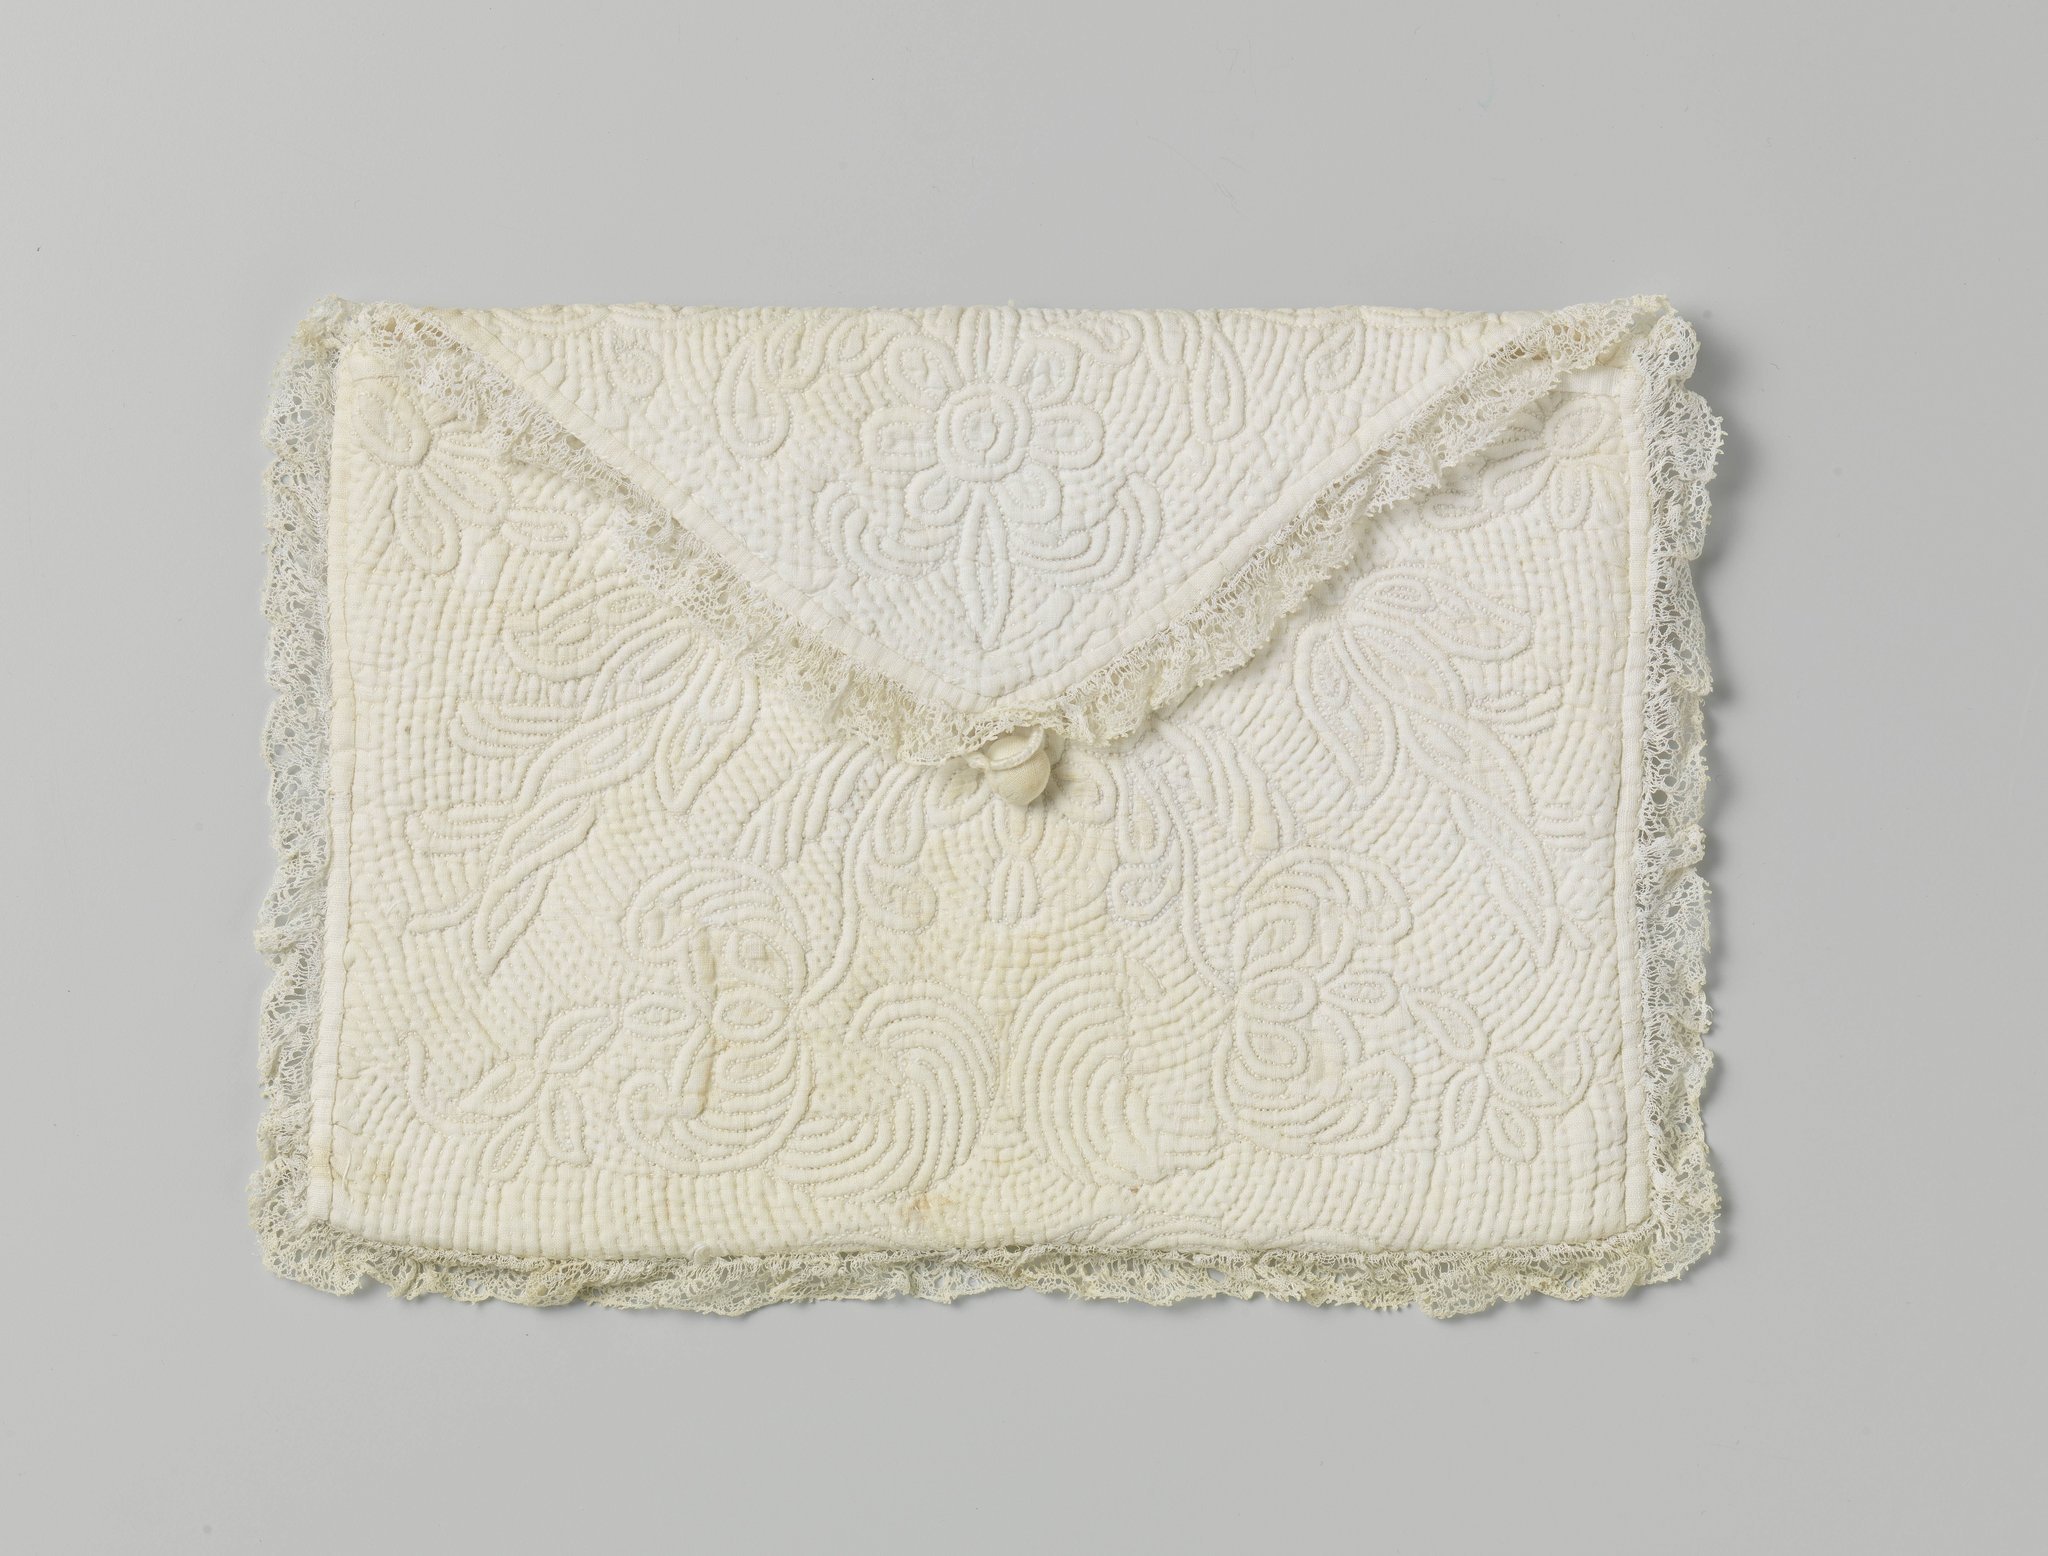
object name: bag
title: Brieventas van witte katoen versierd met florale motieven in 'point de Marseille' of Zaans stikwerk, rondom afgezet met een smalle strook kloskant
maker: Anonymous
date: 1750-1770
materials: cotton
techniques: lace, quilting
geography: zaanstreek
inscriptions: circumscription: ‘'Zaans stikwerk, 18e eeuw, met kloskant. Zakje voor speldenkussen. Het is uitgevoerd in Zaans Stikwerk. Beschrijving van hierboven. Het is versierd met een eenvoudig kantje. Geschenk van mevrouw Schuurman-Meeters te Arnhem'’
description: Brieventas van witte katoen versierd met florale motieven in 'point de Marseille' of Zaans stikwerk, rondom afgezet met een smalle strook kloskant. Het stikwerk heeft een symmetrische opbouw van gestileerde bloemmotieven. De rand is afgezet met een kanten boord. Aan de punt van de klep een lus, die om de met effen katoen omvouwde knoop midden op de tas geslagen kan worden. De binnenkant is aan de achterkant gedeeltelijk gevoerd onversierd katoen. Zaans stikwerk.